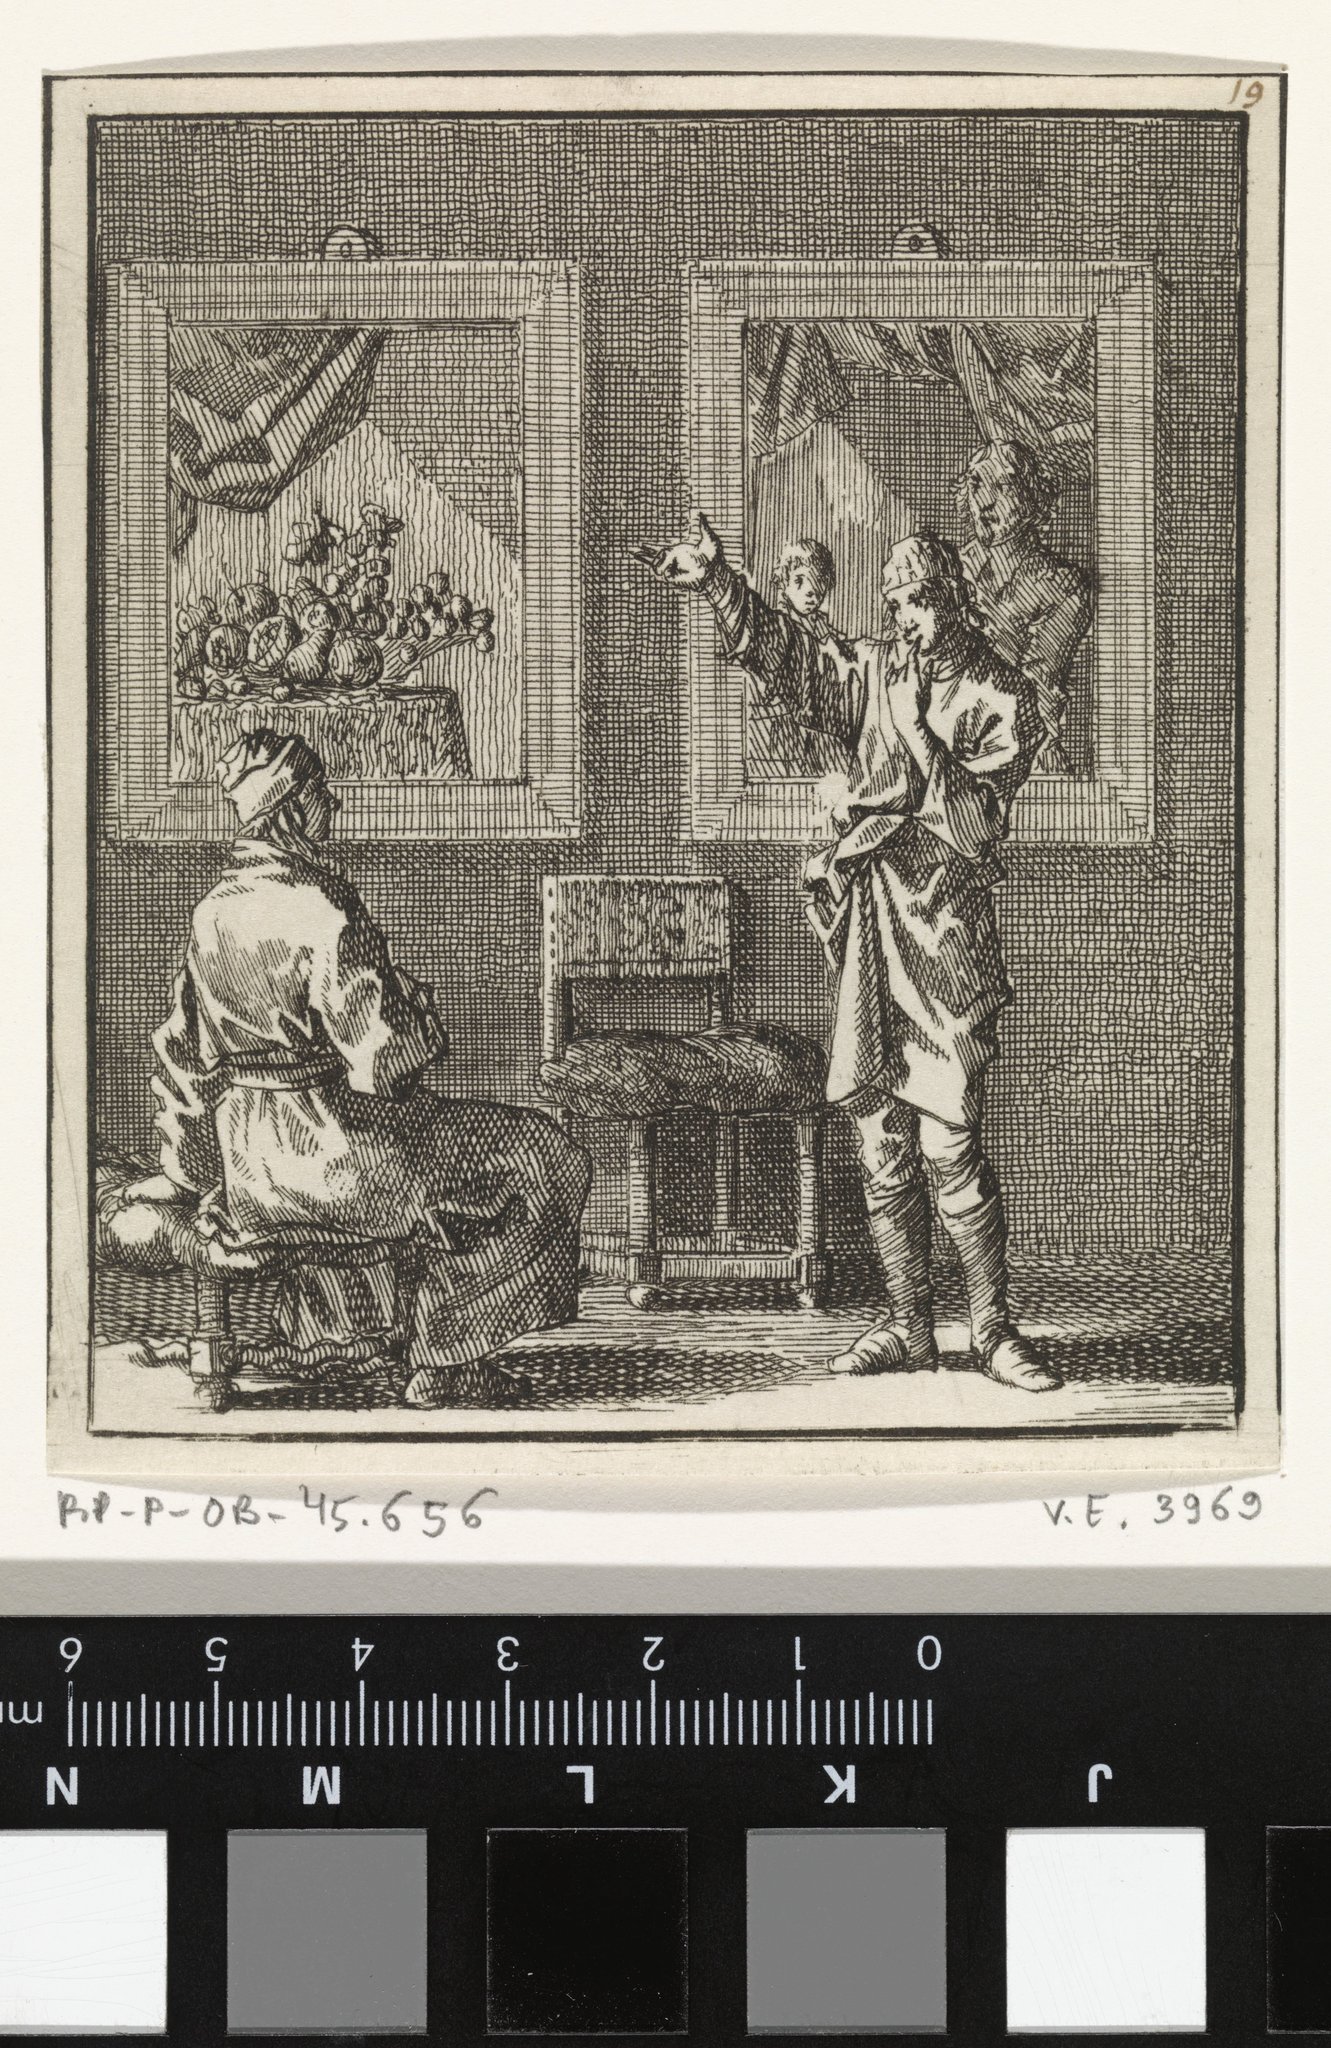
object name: print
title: De Schildery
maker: jan luyken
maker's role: draughtsman, print maker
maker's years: 1649-1712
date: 1711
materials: paper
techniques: etching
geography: amsterdam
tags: picture within picture, picture, painting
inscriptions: collector's mark: Lugt 2228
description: Proefdruk van illustratie voor: Luyken, Jan. Het leerzaam huisraad, vertoond in vyftig konstige figuuren, met godlyke spreuken en stichtelyke verzen: Pieter Arentsz. II (wed.) en Cornelis van der Sys, 1711, p. 68.